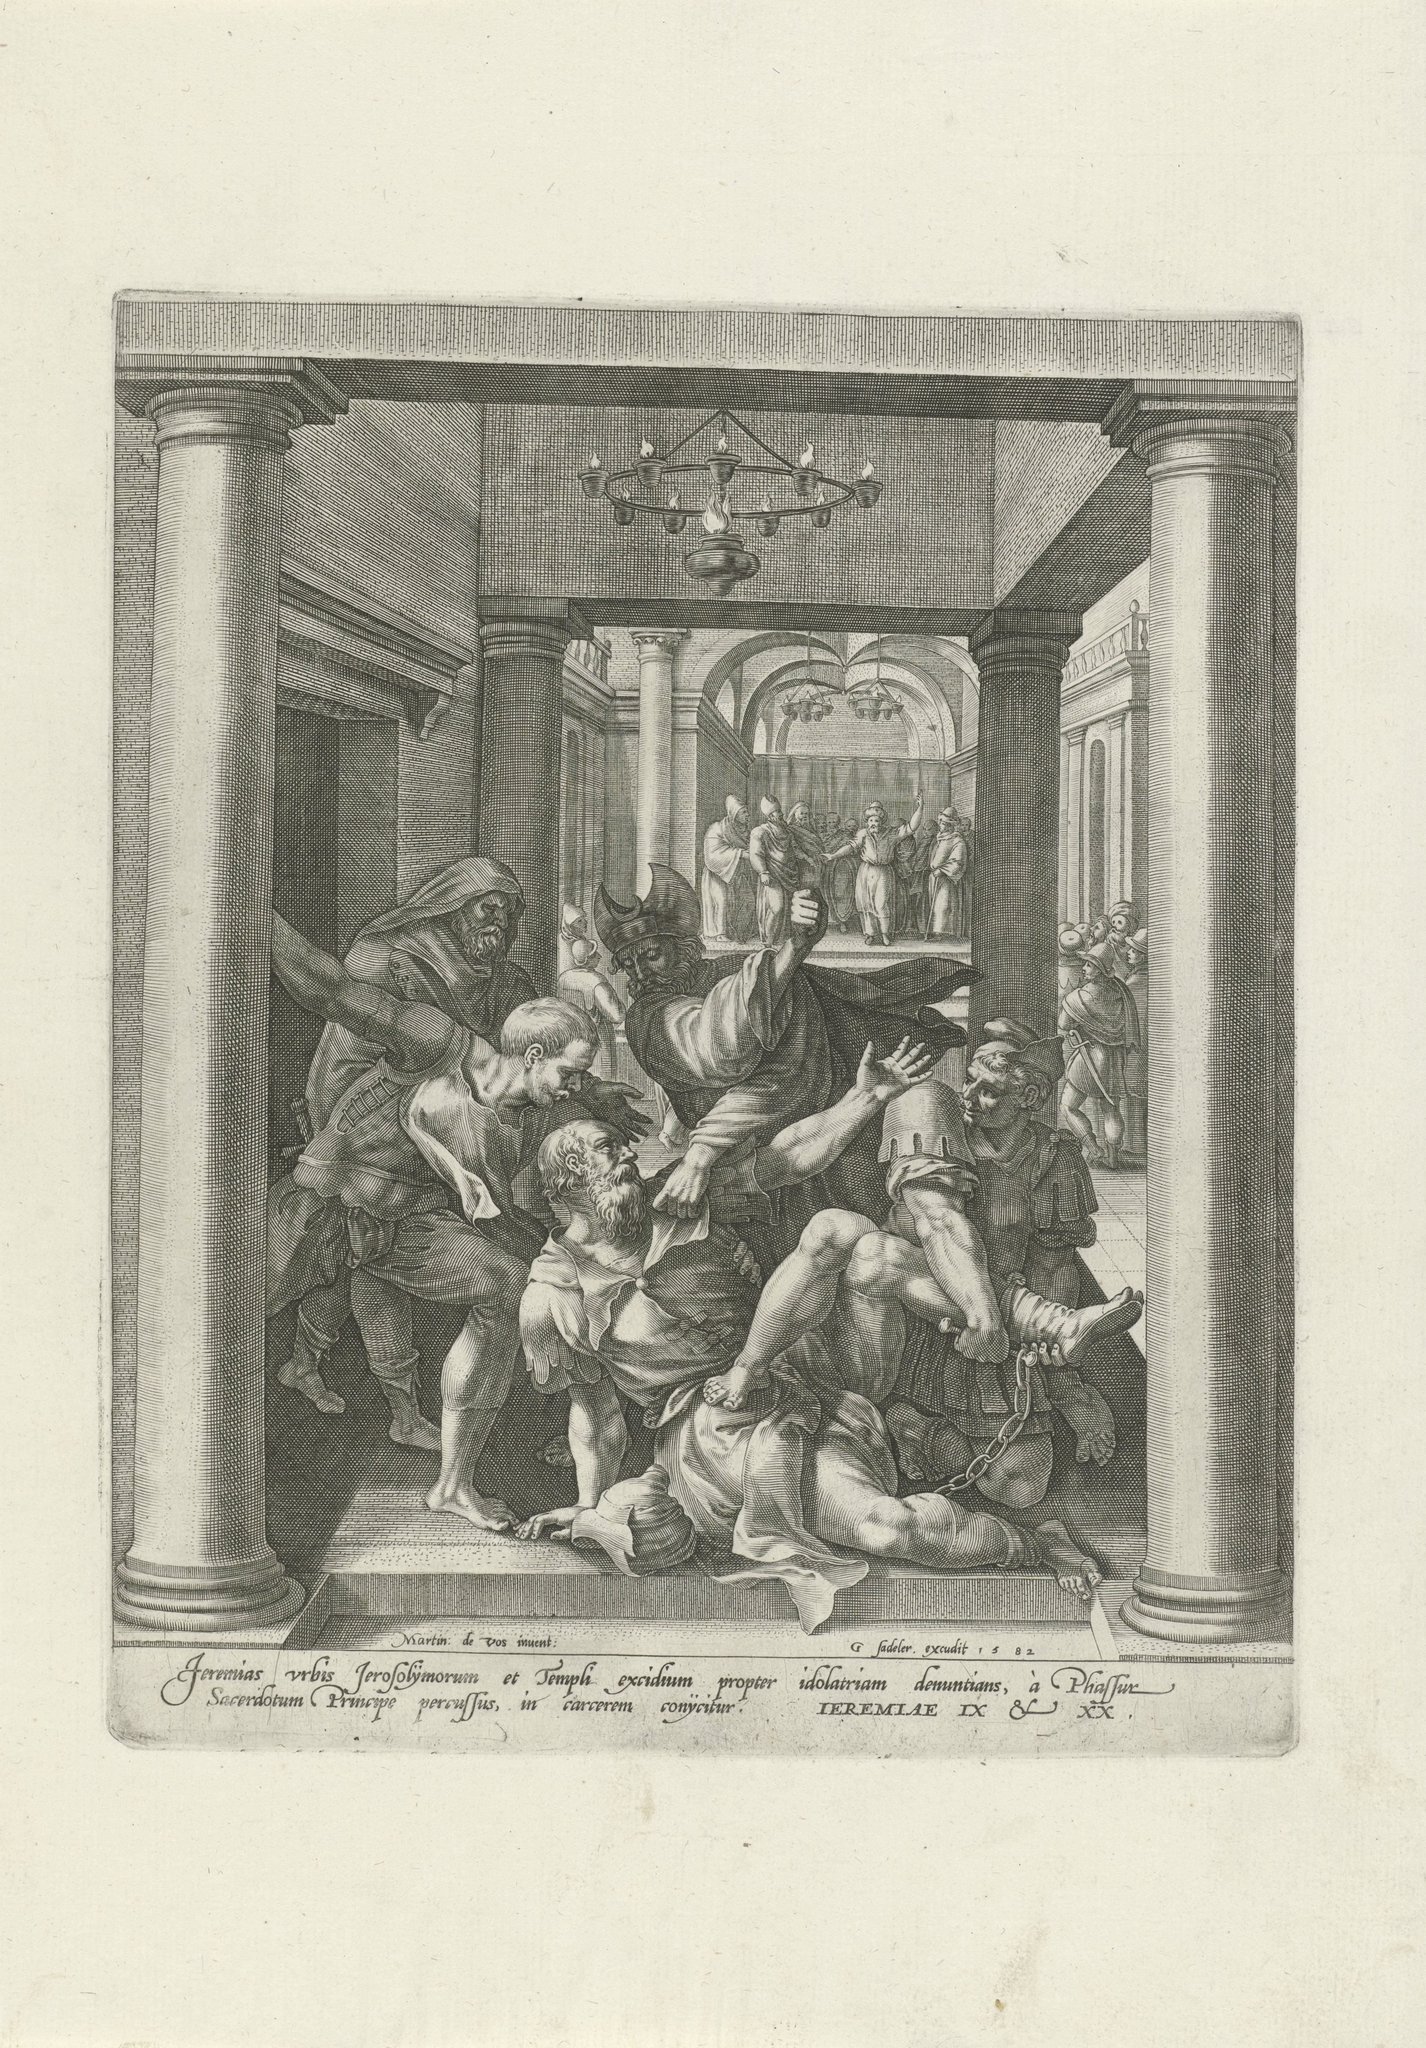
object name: print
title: Scènes uit het Oude Testament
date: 1582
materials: paper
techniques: engraving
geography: cologne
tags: jeremiah preaching and prophesying in the temple court, jeremiah tortured and put in the stocks by pashur in the gate of the temple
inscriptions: collector's mark: Lugt 2228, collector's mark: Lugt 2760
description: De profeet Jeremia wordt bij de tempelingang door de priester Paschur geslagen. Zijn handlangers slaan de profeet in ketens en werpen hem in de kerker. Op de achterhand preekt Jeremia voor een menigte in de tempel. De prent heeft een Latijns onderschrift met uitleg uit het Oude Testament en is de achtste prent van een elfdelige serie.